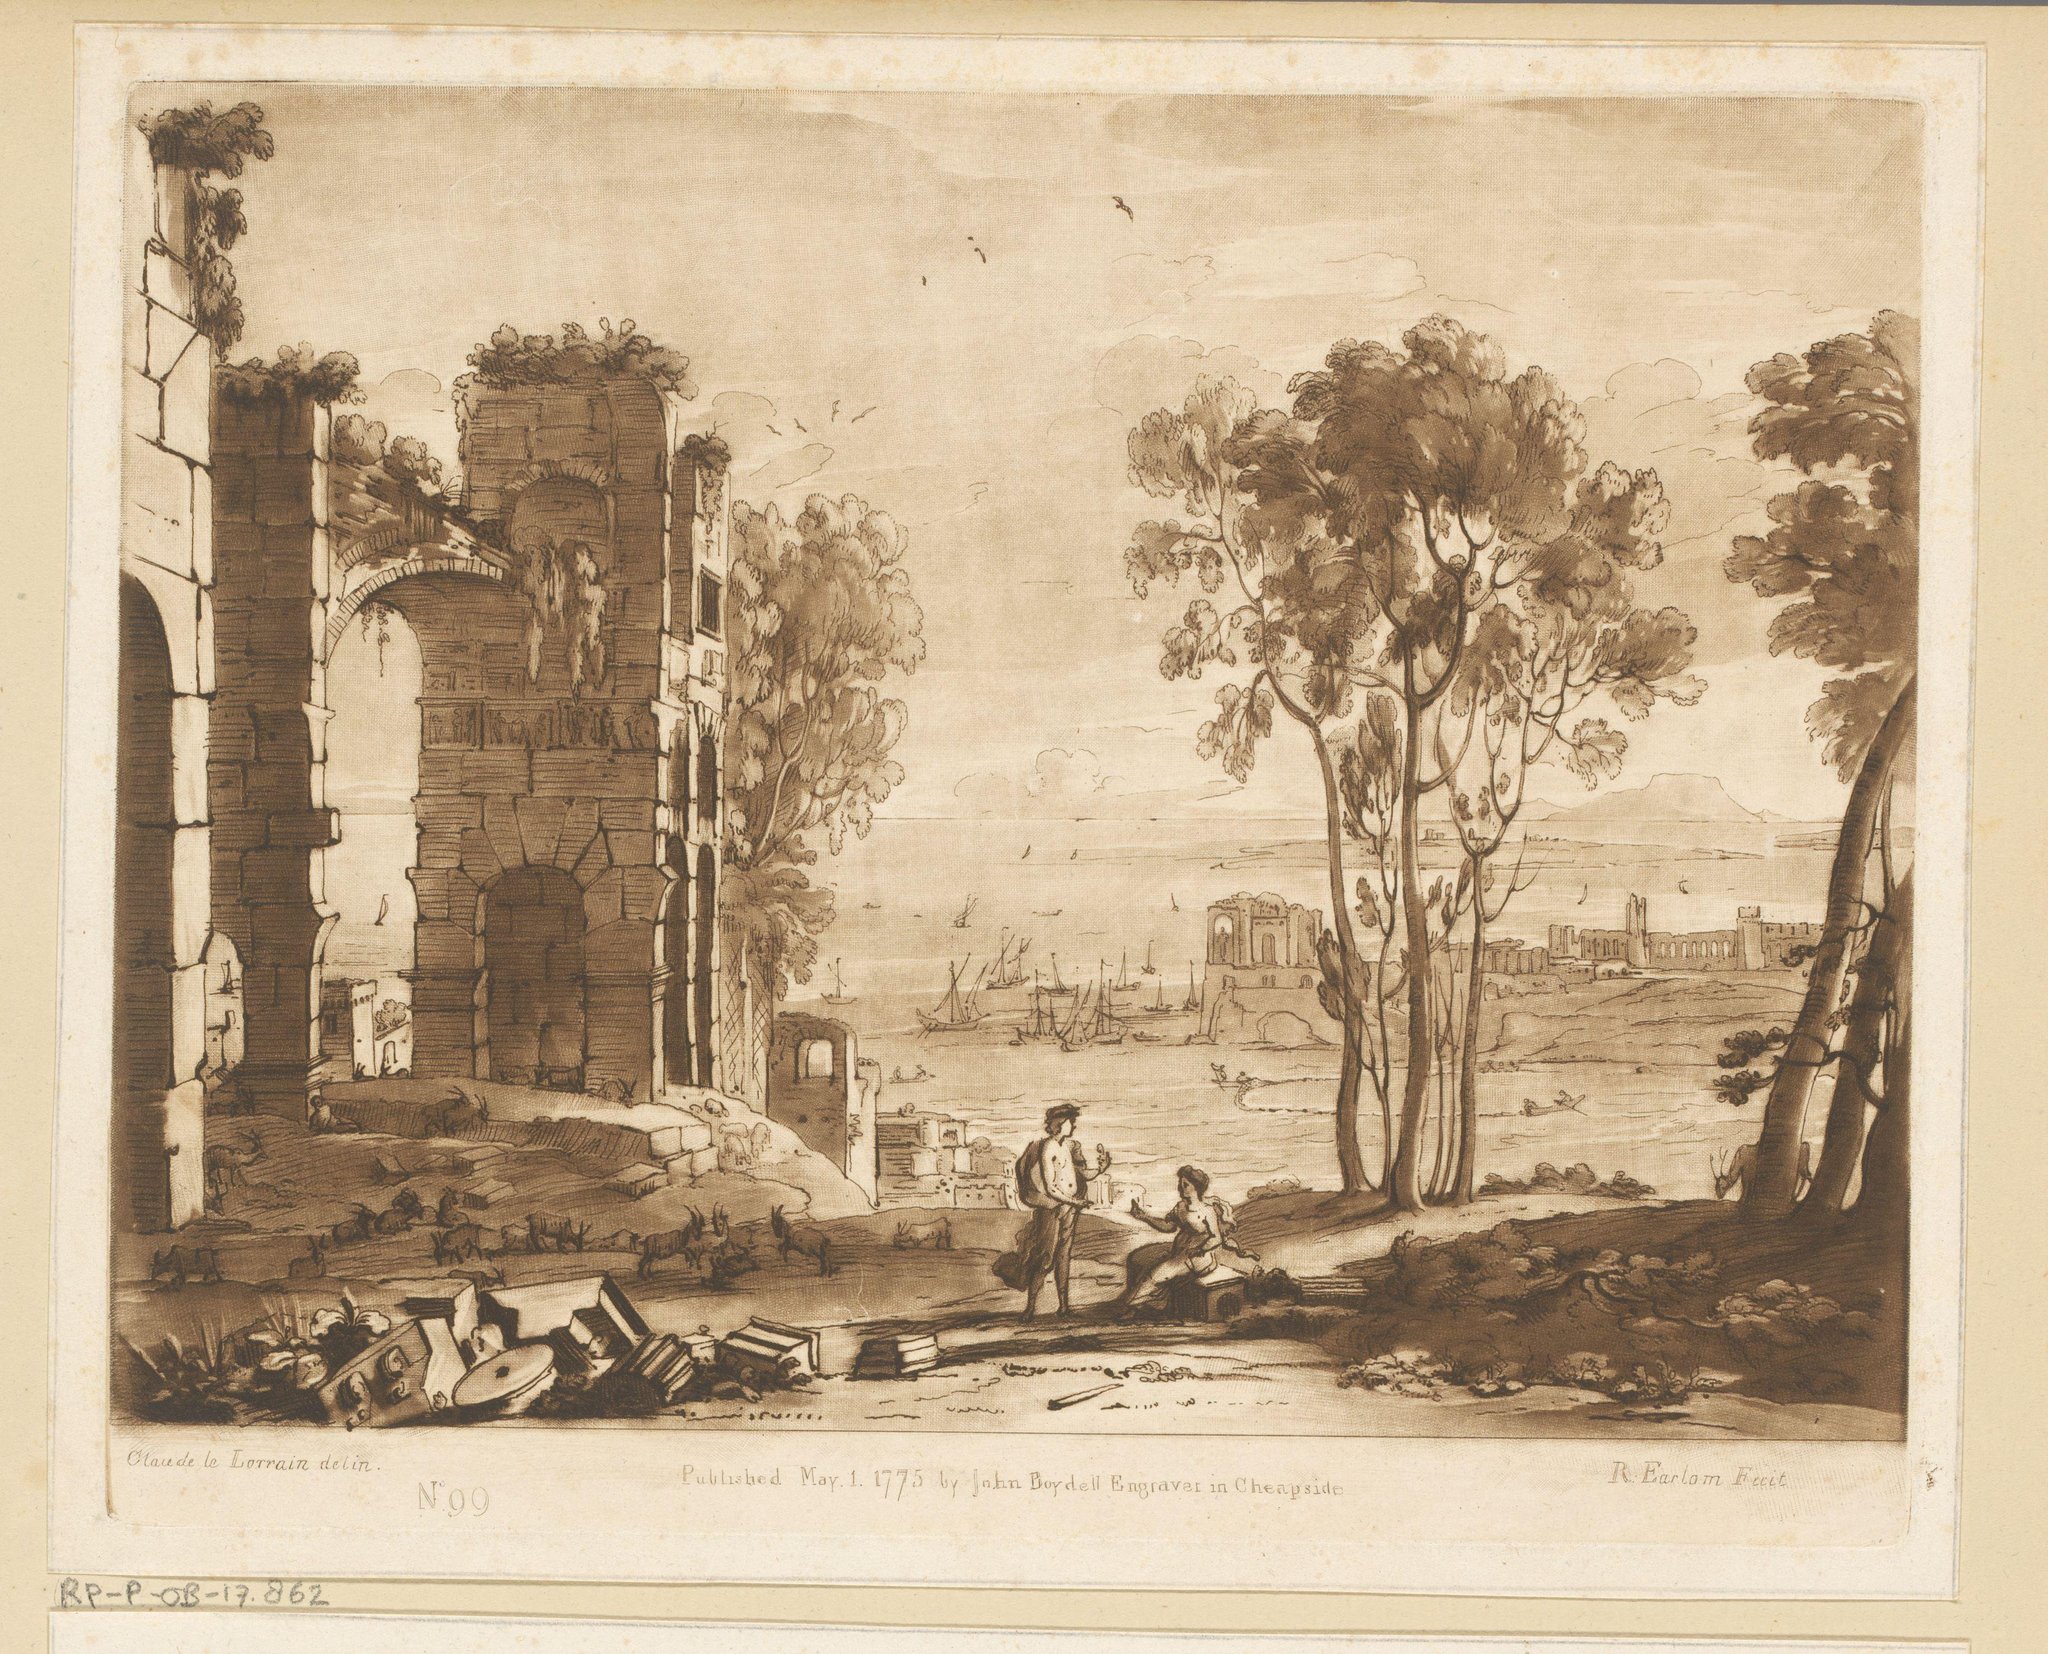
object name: print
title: Prenten naar tekeningen van Claude Lorrain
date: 1775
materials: paper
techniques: etching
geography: london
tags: coast - hh - ideal landscapes, the cumaean sibyl is granted long life: apollo grants the cumaean sibyl as many years as she has grains of sand in her hand, in return for her love (ovid, metamorphoses xiv 136), landscape with ruins - ii - ideal landscapes, landscapes with waters, waterscapes, seascapes (in the temperate zone) - hh - ideal landscapes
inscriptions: date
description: Vanaf 1774 publiceerde John Boydell tweehonderd prenten naar het tekeningenboek Liber Veritatis van Claude Lorrain, in het bezit van de hertogen van Cavendish. Deze prenten werden vanaf 1777 in twee volumes gebundeld uitgegeven.